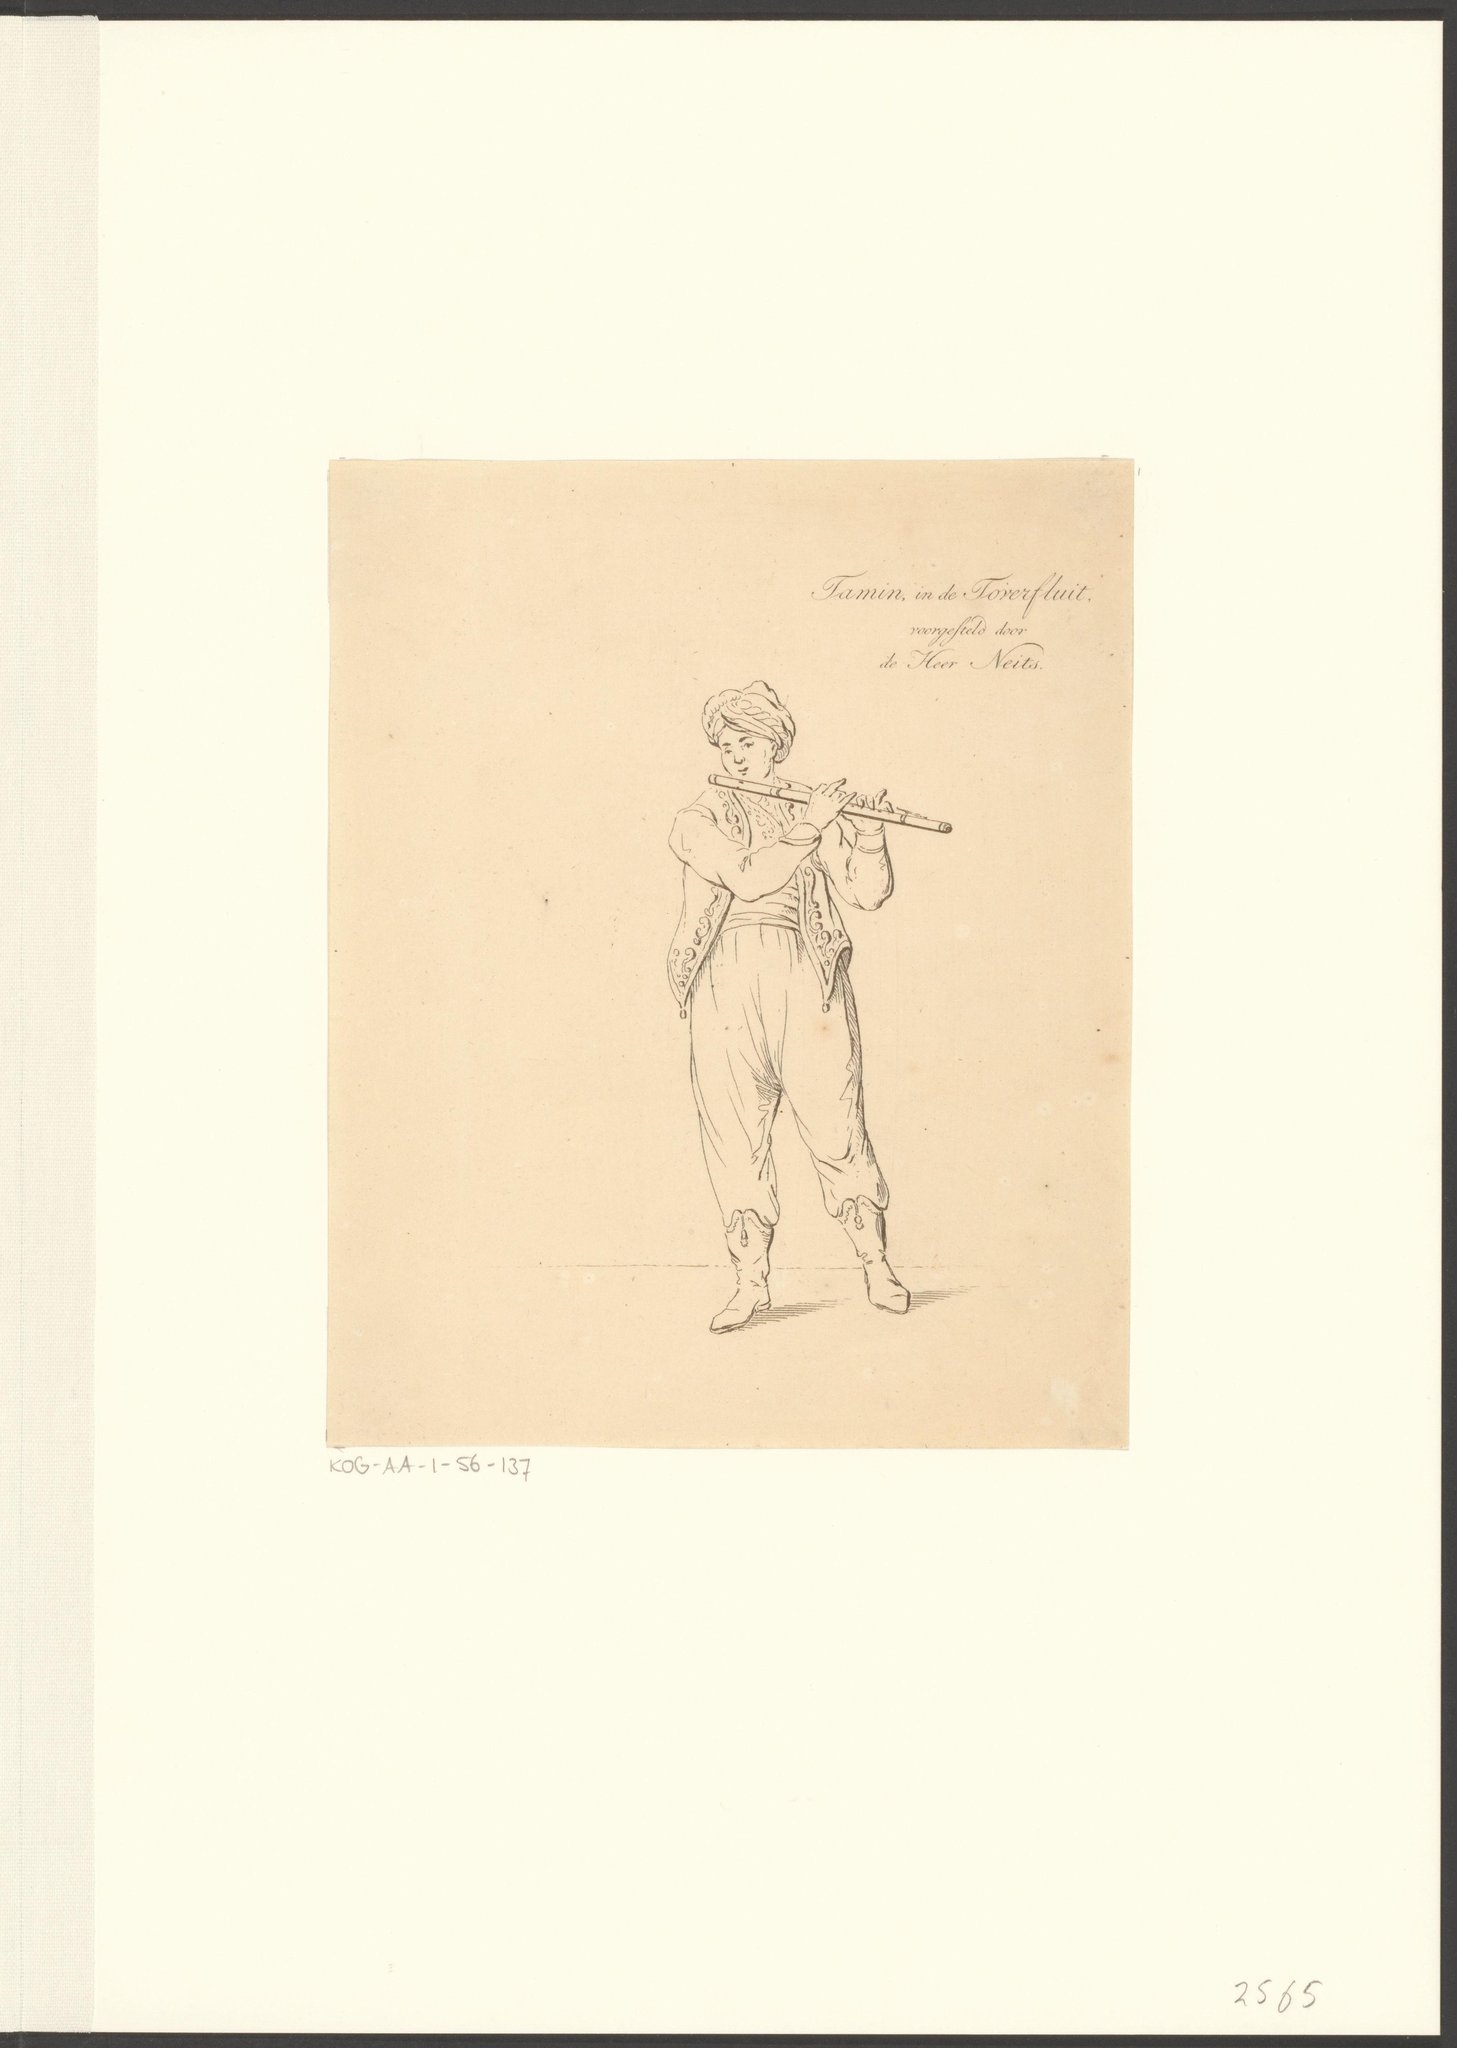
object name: print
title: Portret van toneelspeler Johannes Neyts als Tamin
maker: johannes jelgerhuis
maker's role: draughtsman, painter, print maker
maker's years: 1770-1836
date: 1788-1836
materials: paper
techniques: etching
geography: amsterdam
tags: historical persons, portrait of actor, actress, actor (on the stage), amsterdam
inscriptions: inscription: ‘Tamin, in de Toverfluit, / voorgesteld door / de Heer Neits.’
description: Onderwerpsrubriek binnen de Atlas Amsterdam: Verschillende andere schouwburgen.